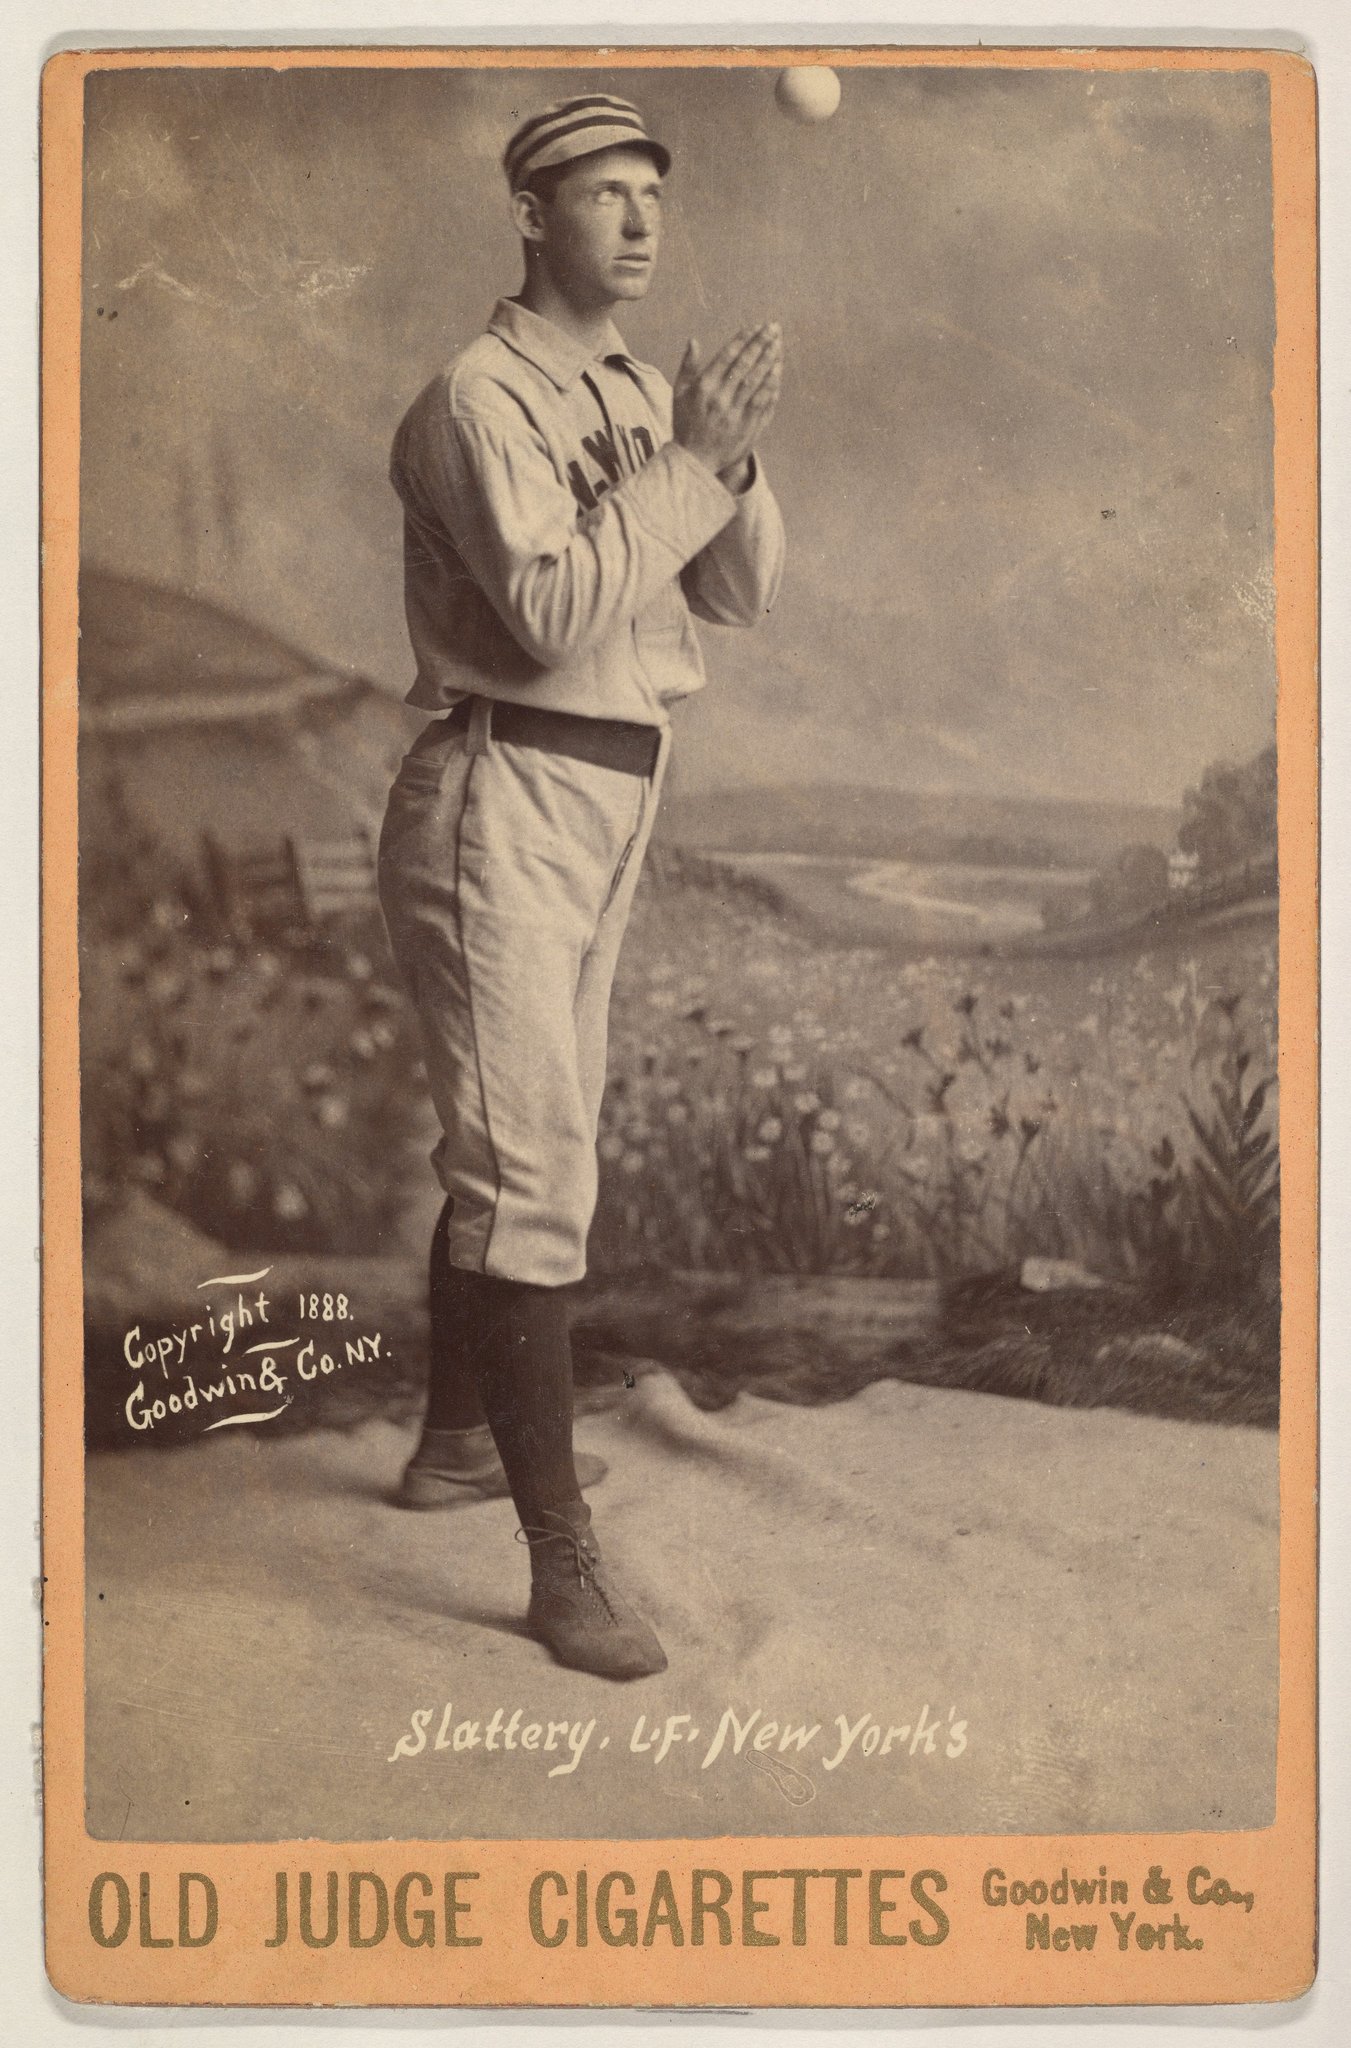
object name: baseball card, photograph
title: Slattery, Left Field, New York, from the series Old Judge Cigarettes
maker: goodwin & company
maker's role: publisher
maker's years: 1850-1950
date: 1888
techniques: albumen silver print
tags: men,portraits,baseball,athletes